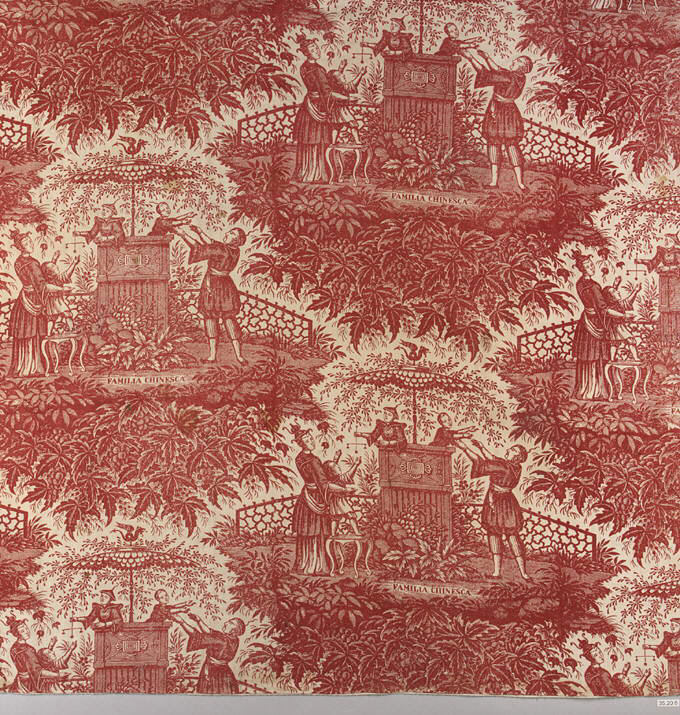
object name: piece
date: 1826-1850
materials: cotton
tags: birds,men,women,leaves